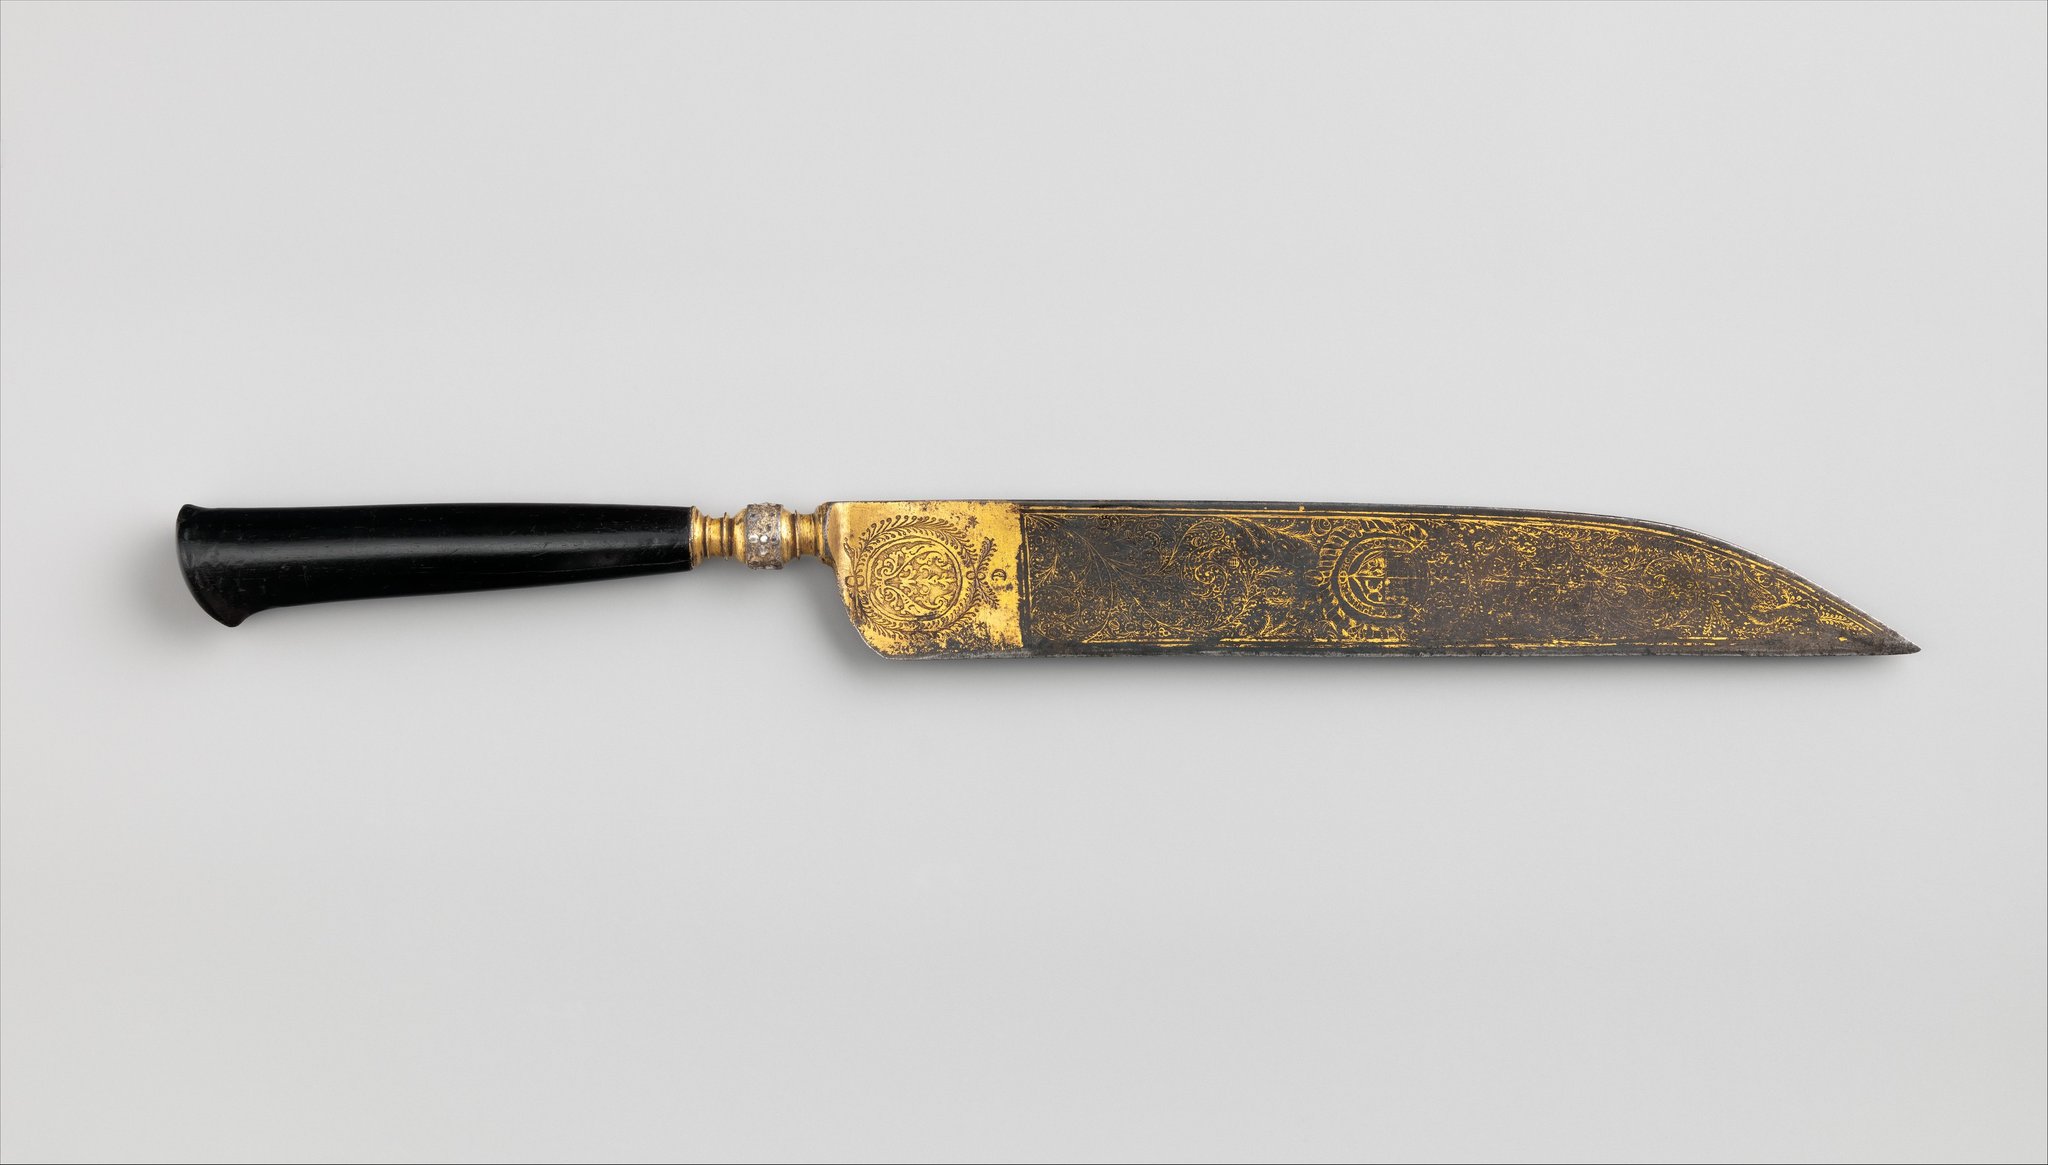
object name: knife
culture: italian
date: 1601-1700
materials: gold, steel, wood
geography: italy